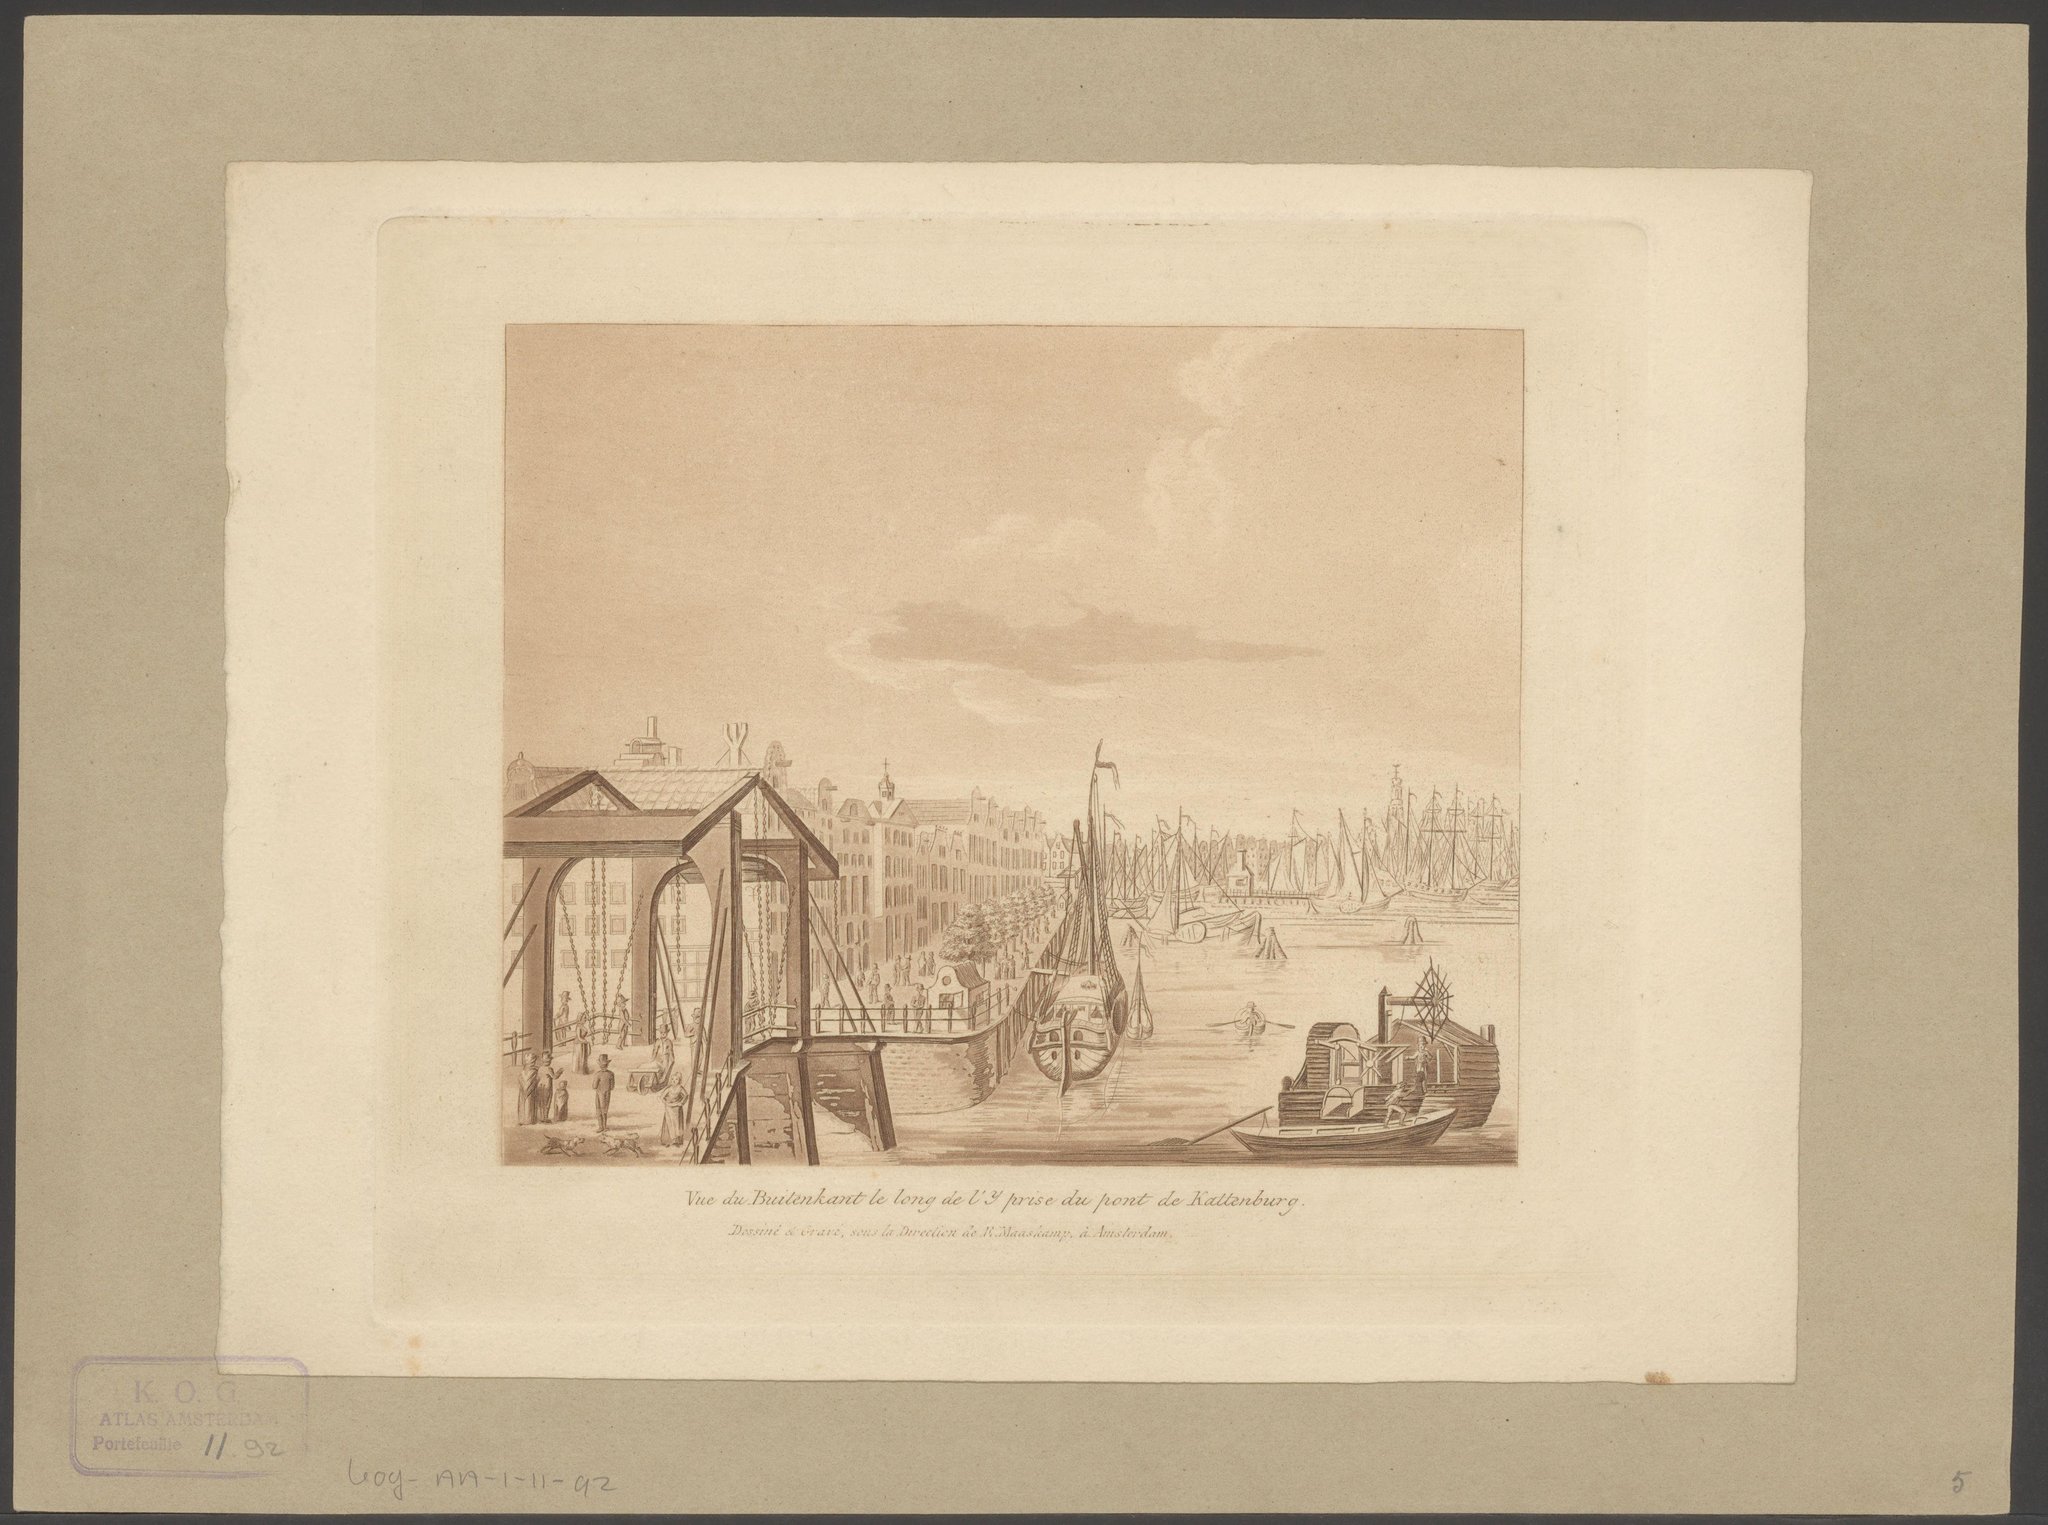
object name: print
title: Vue du Buitenkant le long de l'Y prise du pont de Kattenburg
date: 1810-1813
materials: paper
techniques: aquatint, engraving, etching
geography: amsterdam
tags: sailing-ship, sailing-boat, city-view in general; 'veduta', river, bridge in city across river, canal, etc., street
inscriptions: collector's mark: ‘11.92’ Lugt 1641b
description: Onderwerpsrubriek binnen de Atlas Amsterdam: Prinsengracht, Korte Prinsengracht, Prins Hendrikkade. Zie ook Portefeuille 1: gezichten van het IJ op de stad.